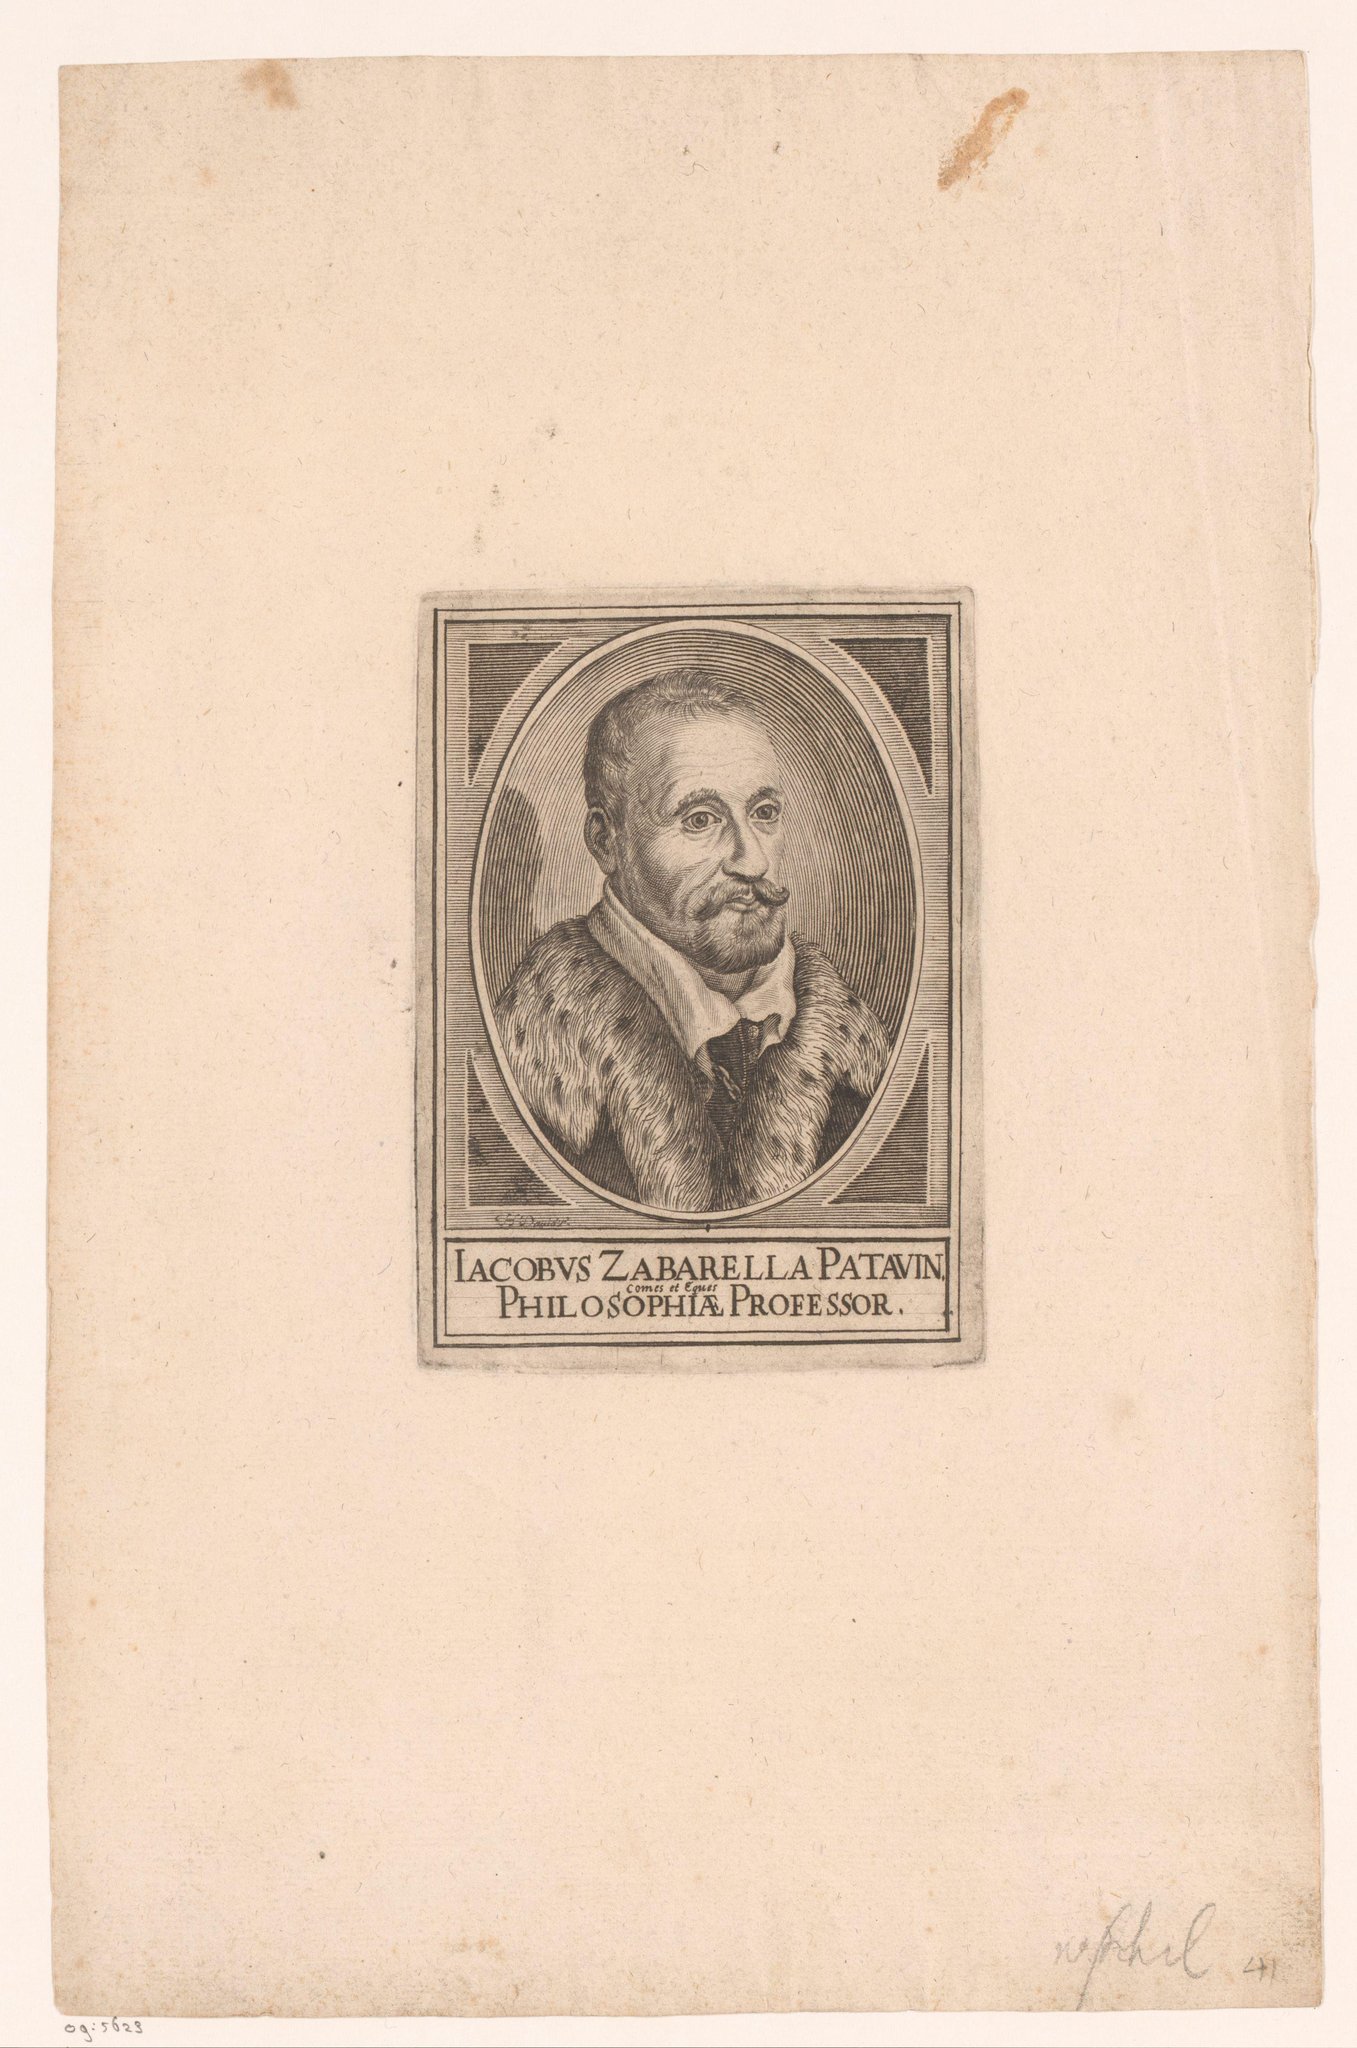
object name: print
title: Jacobus Zabarella Patavin Philosophiae Professor.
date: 1630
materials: paper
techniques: engraving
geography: padua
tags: scholar, philosopher, historical persons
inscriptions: collector's mark: Lugt 2228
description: Prent uit: Tomasini, Jacopo Filippo. Jacobi Philippi Tomasini Patavini Illustrium Virorum Elogia Iconibus Exornata (...). Padua: Donato Pasquardi, 1630, p. 135.